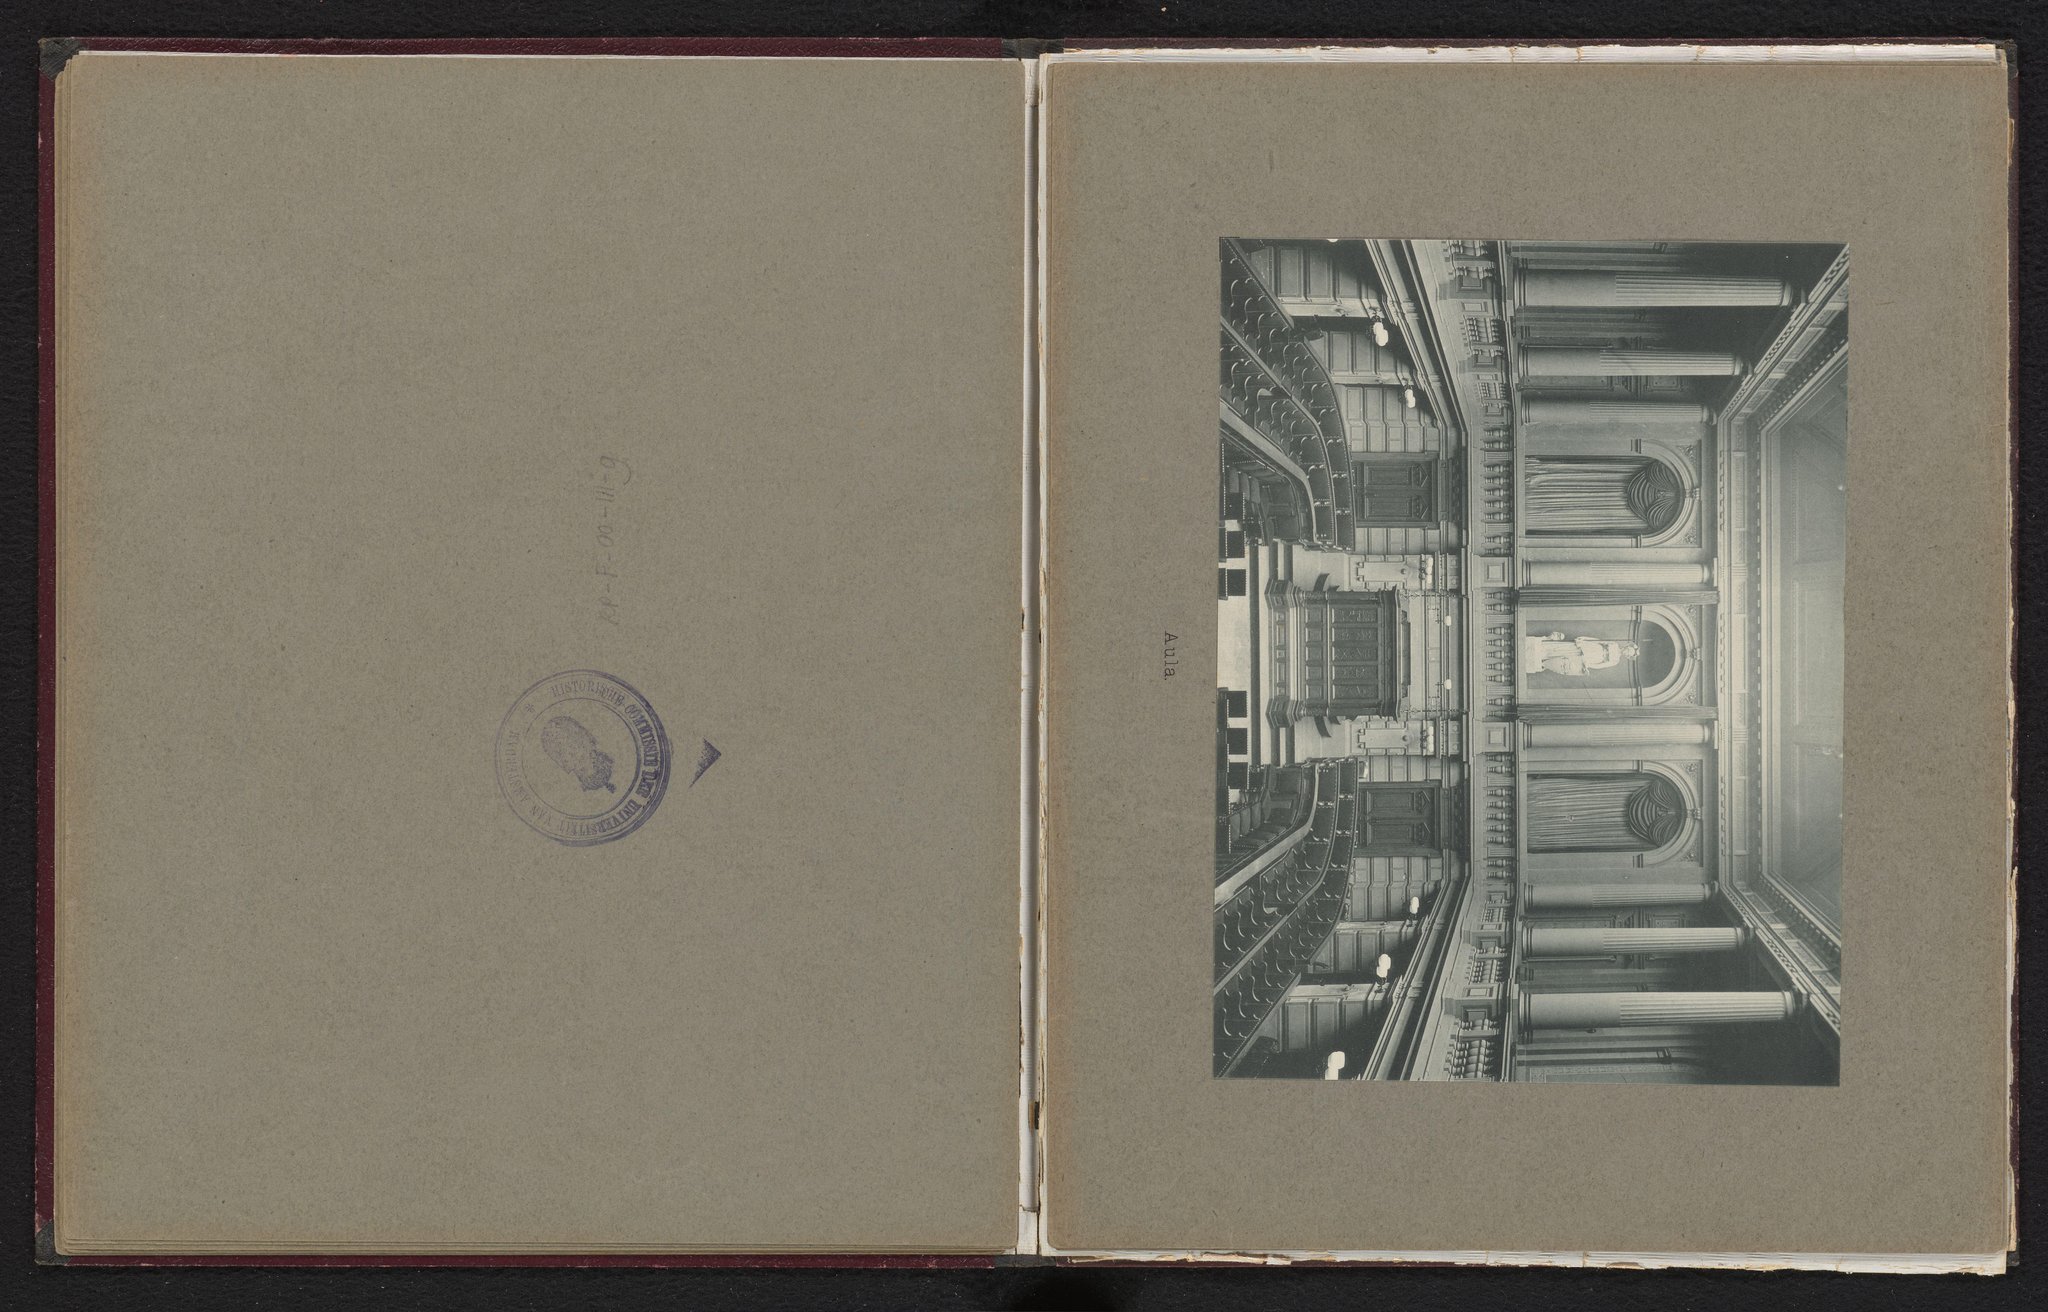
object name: photomechanical print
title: Aula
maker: Anonymous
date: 1902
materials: cardboard, paper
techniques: photograph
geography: amsterdam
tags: university building, college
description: Deze prent maakt deel uit van een omslag met vijftien lichtdrukken op twaalf kartonnen bladen.